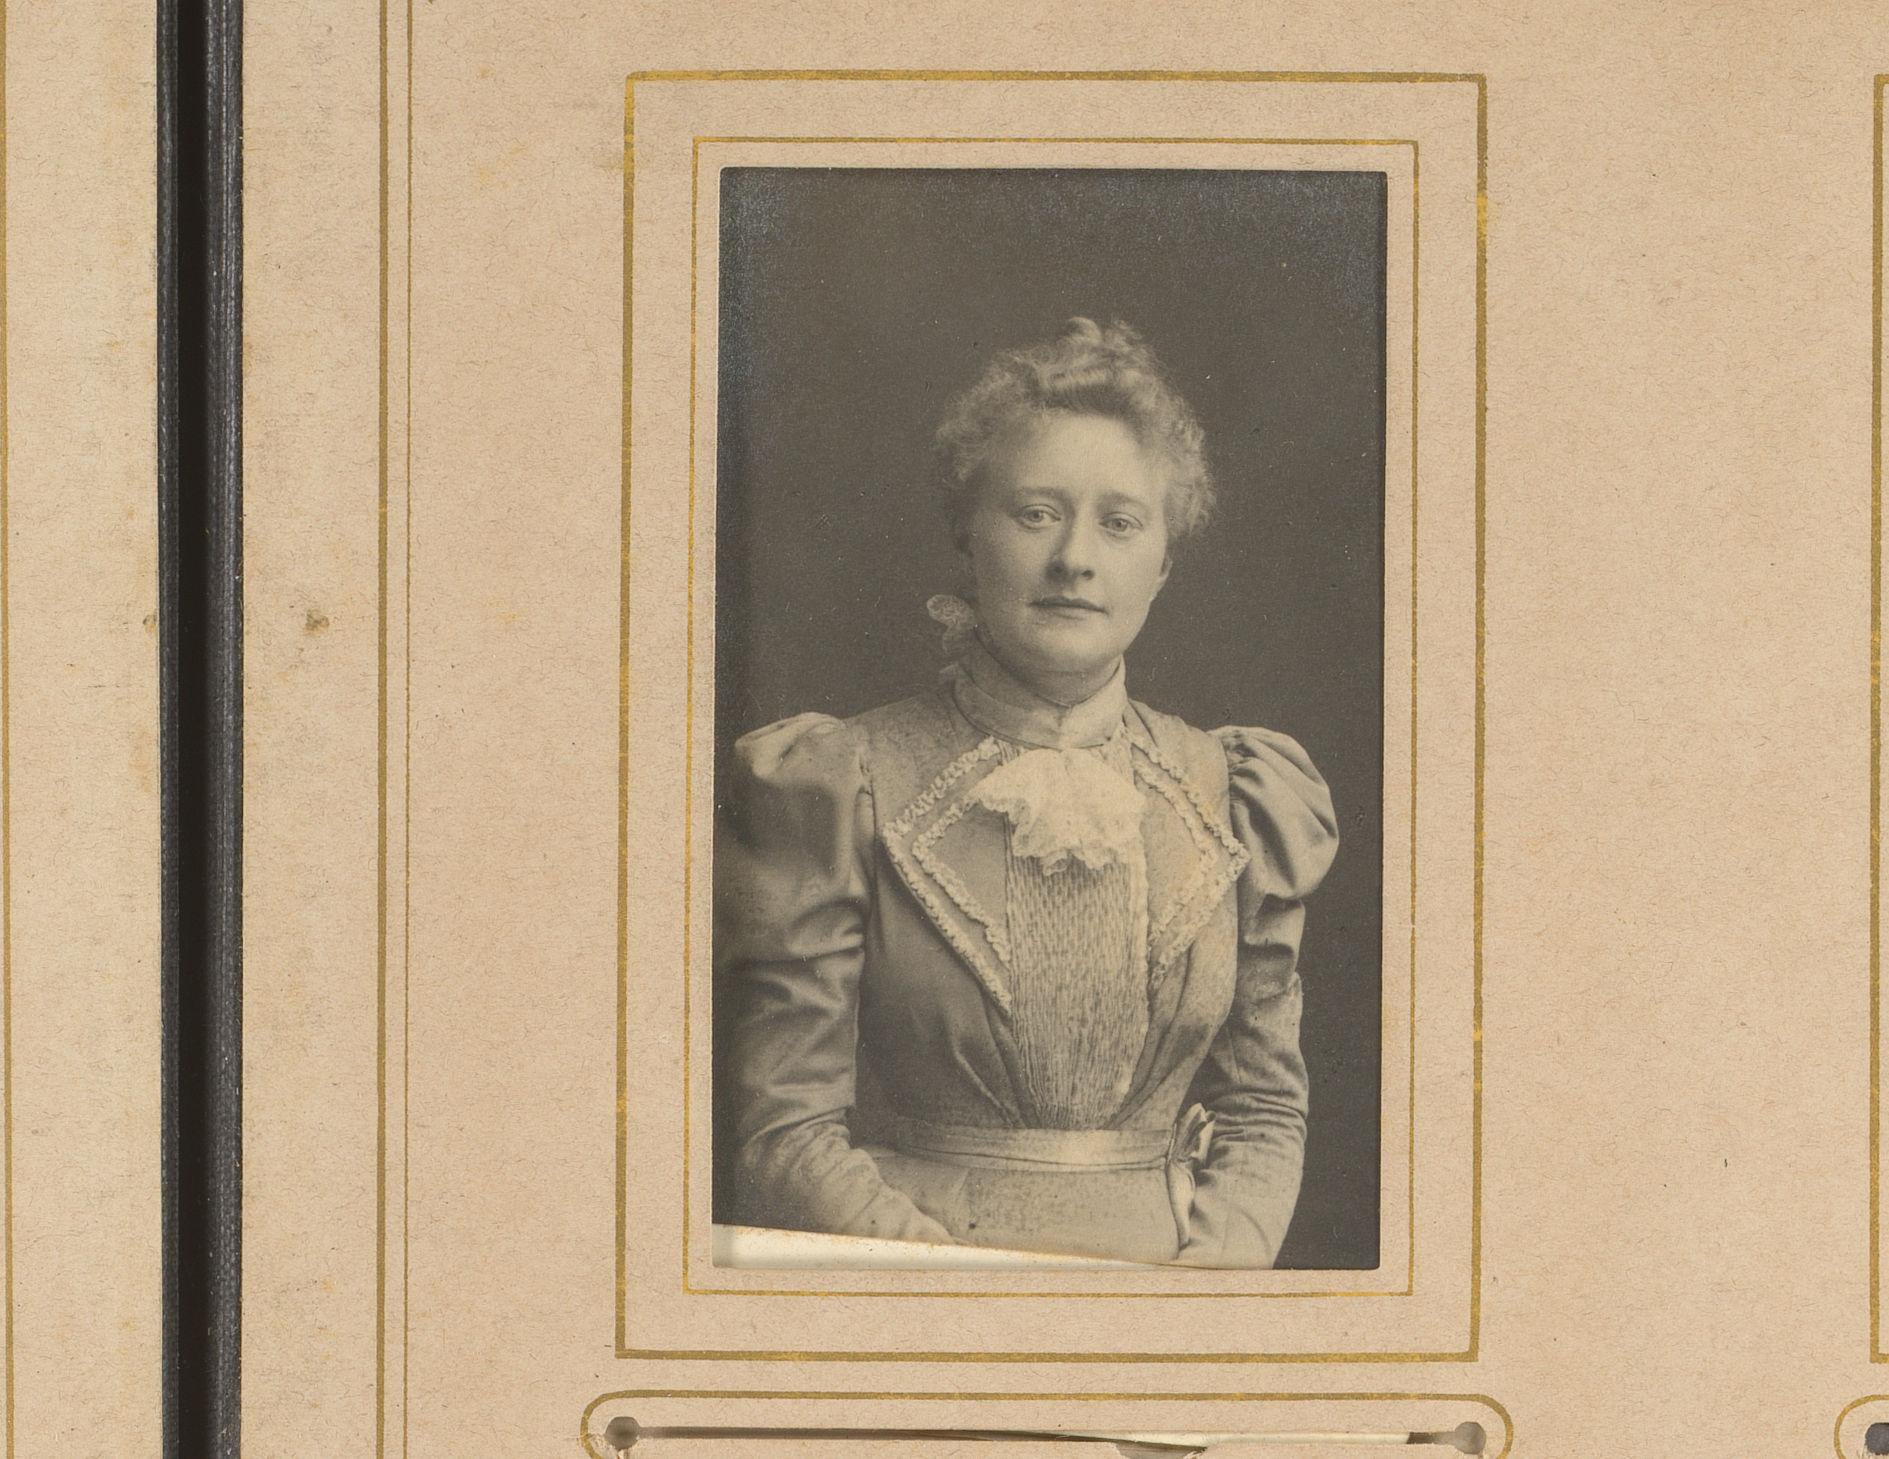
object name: carte de visite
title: Portret van een vrouw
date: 1880-1915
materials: cardboard, photographic support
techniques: gelatin silver print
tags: adult woman, historical persons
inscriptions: name: ‘J. De Smet st Fils rue Mertens 36/ Mont St Amand’, inscription: ‘Portraits/ Photo-peinture/ & Dessin/ J. Desmet&Fils/ 36 Rue Mertens’